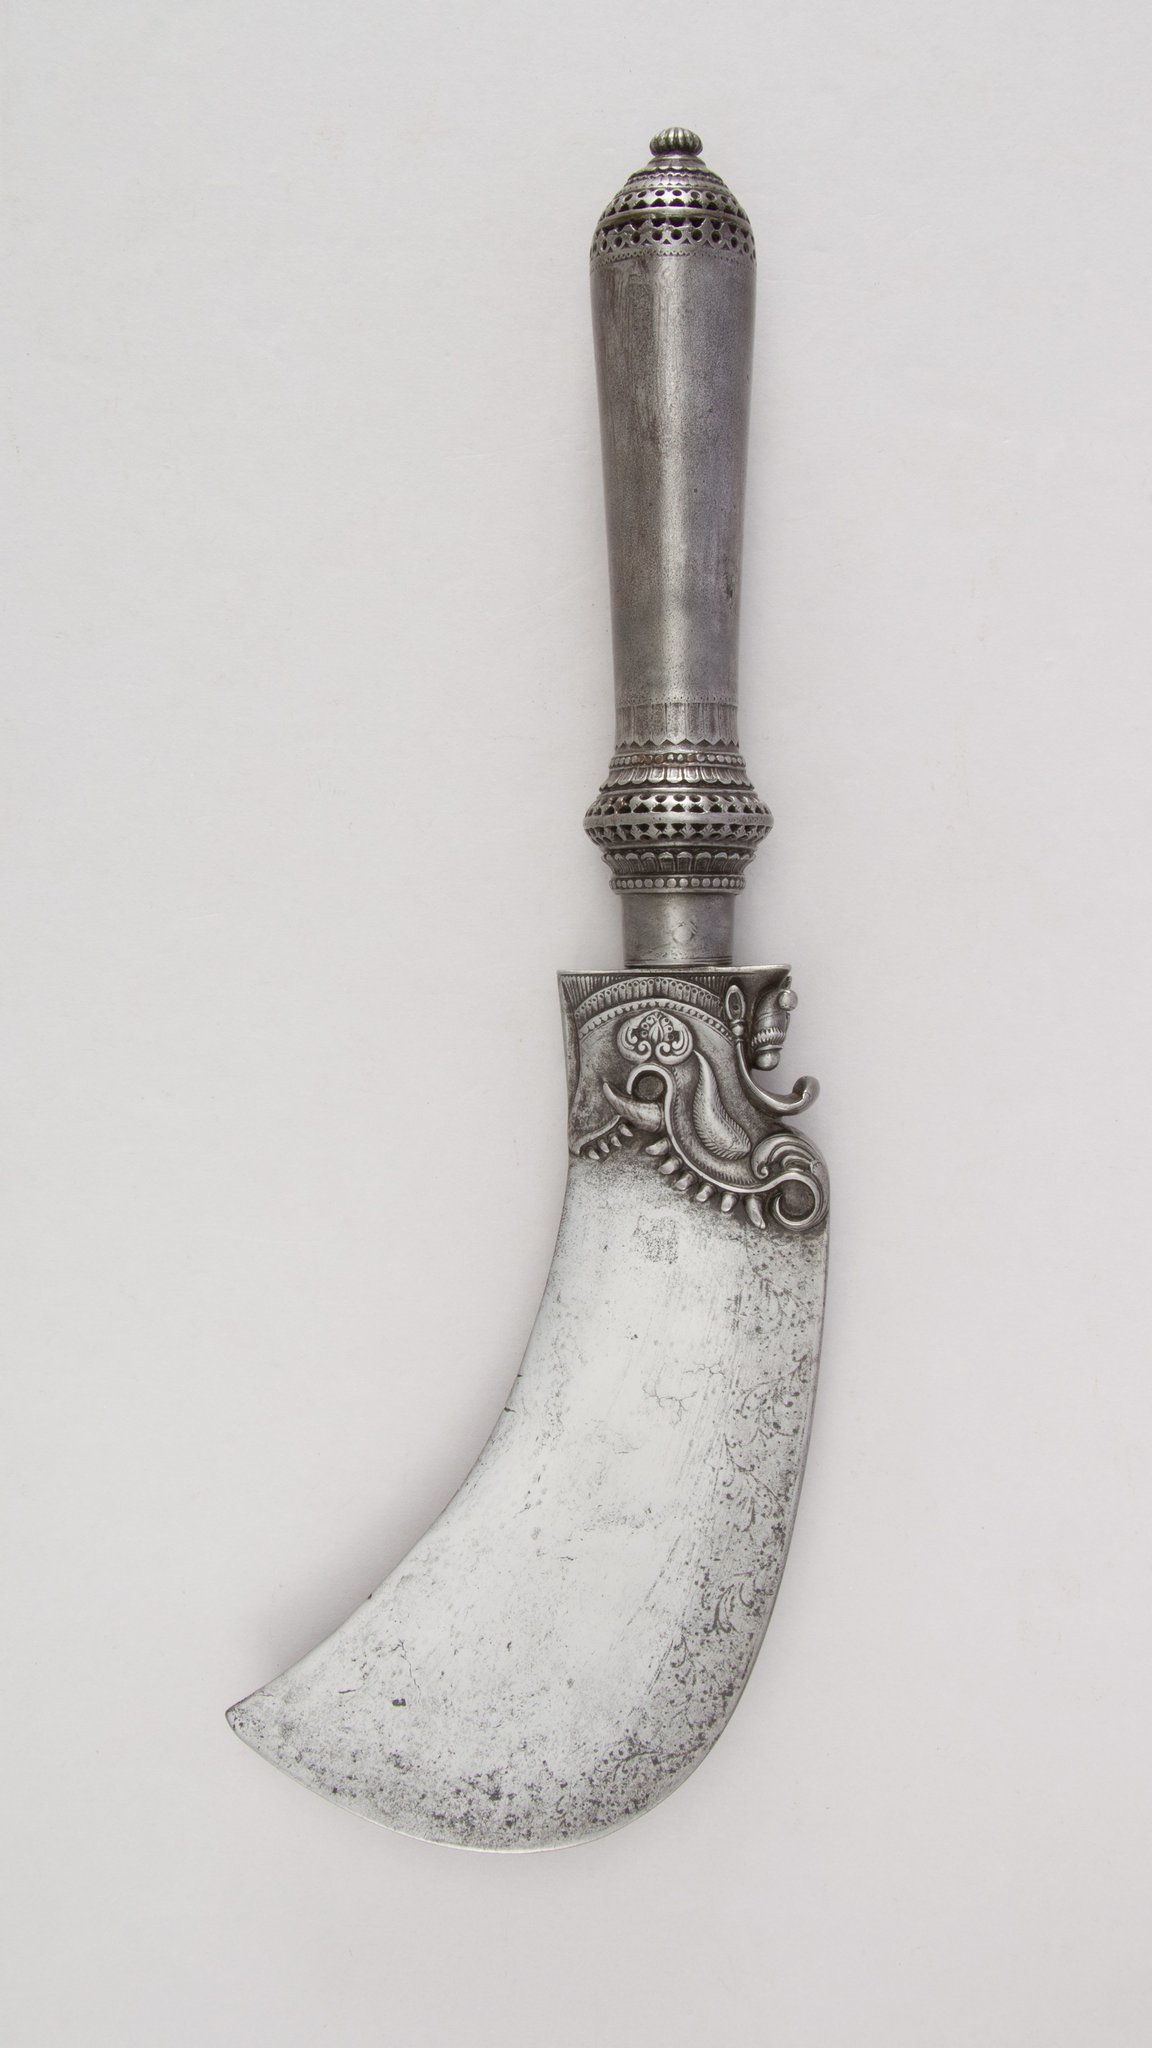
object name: sacrifical axe matchu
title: Sacrifical Axe (Matchu)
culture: indian, thanjavur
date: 1601-1800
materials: steel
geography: india